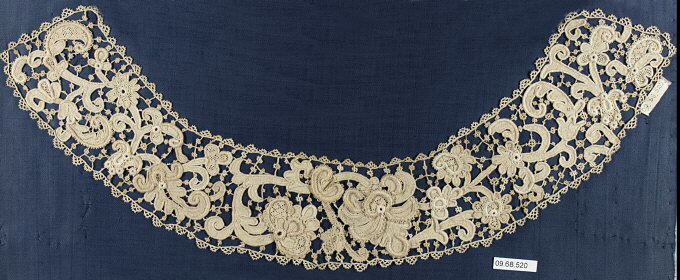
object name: collar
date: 1801-1900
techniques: lace